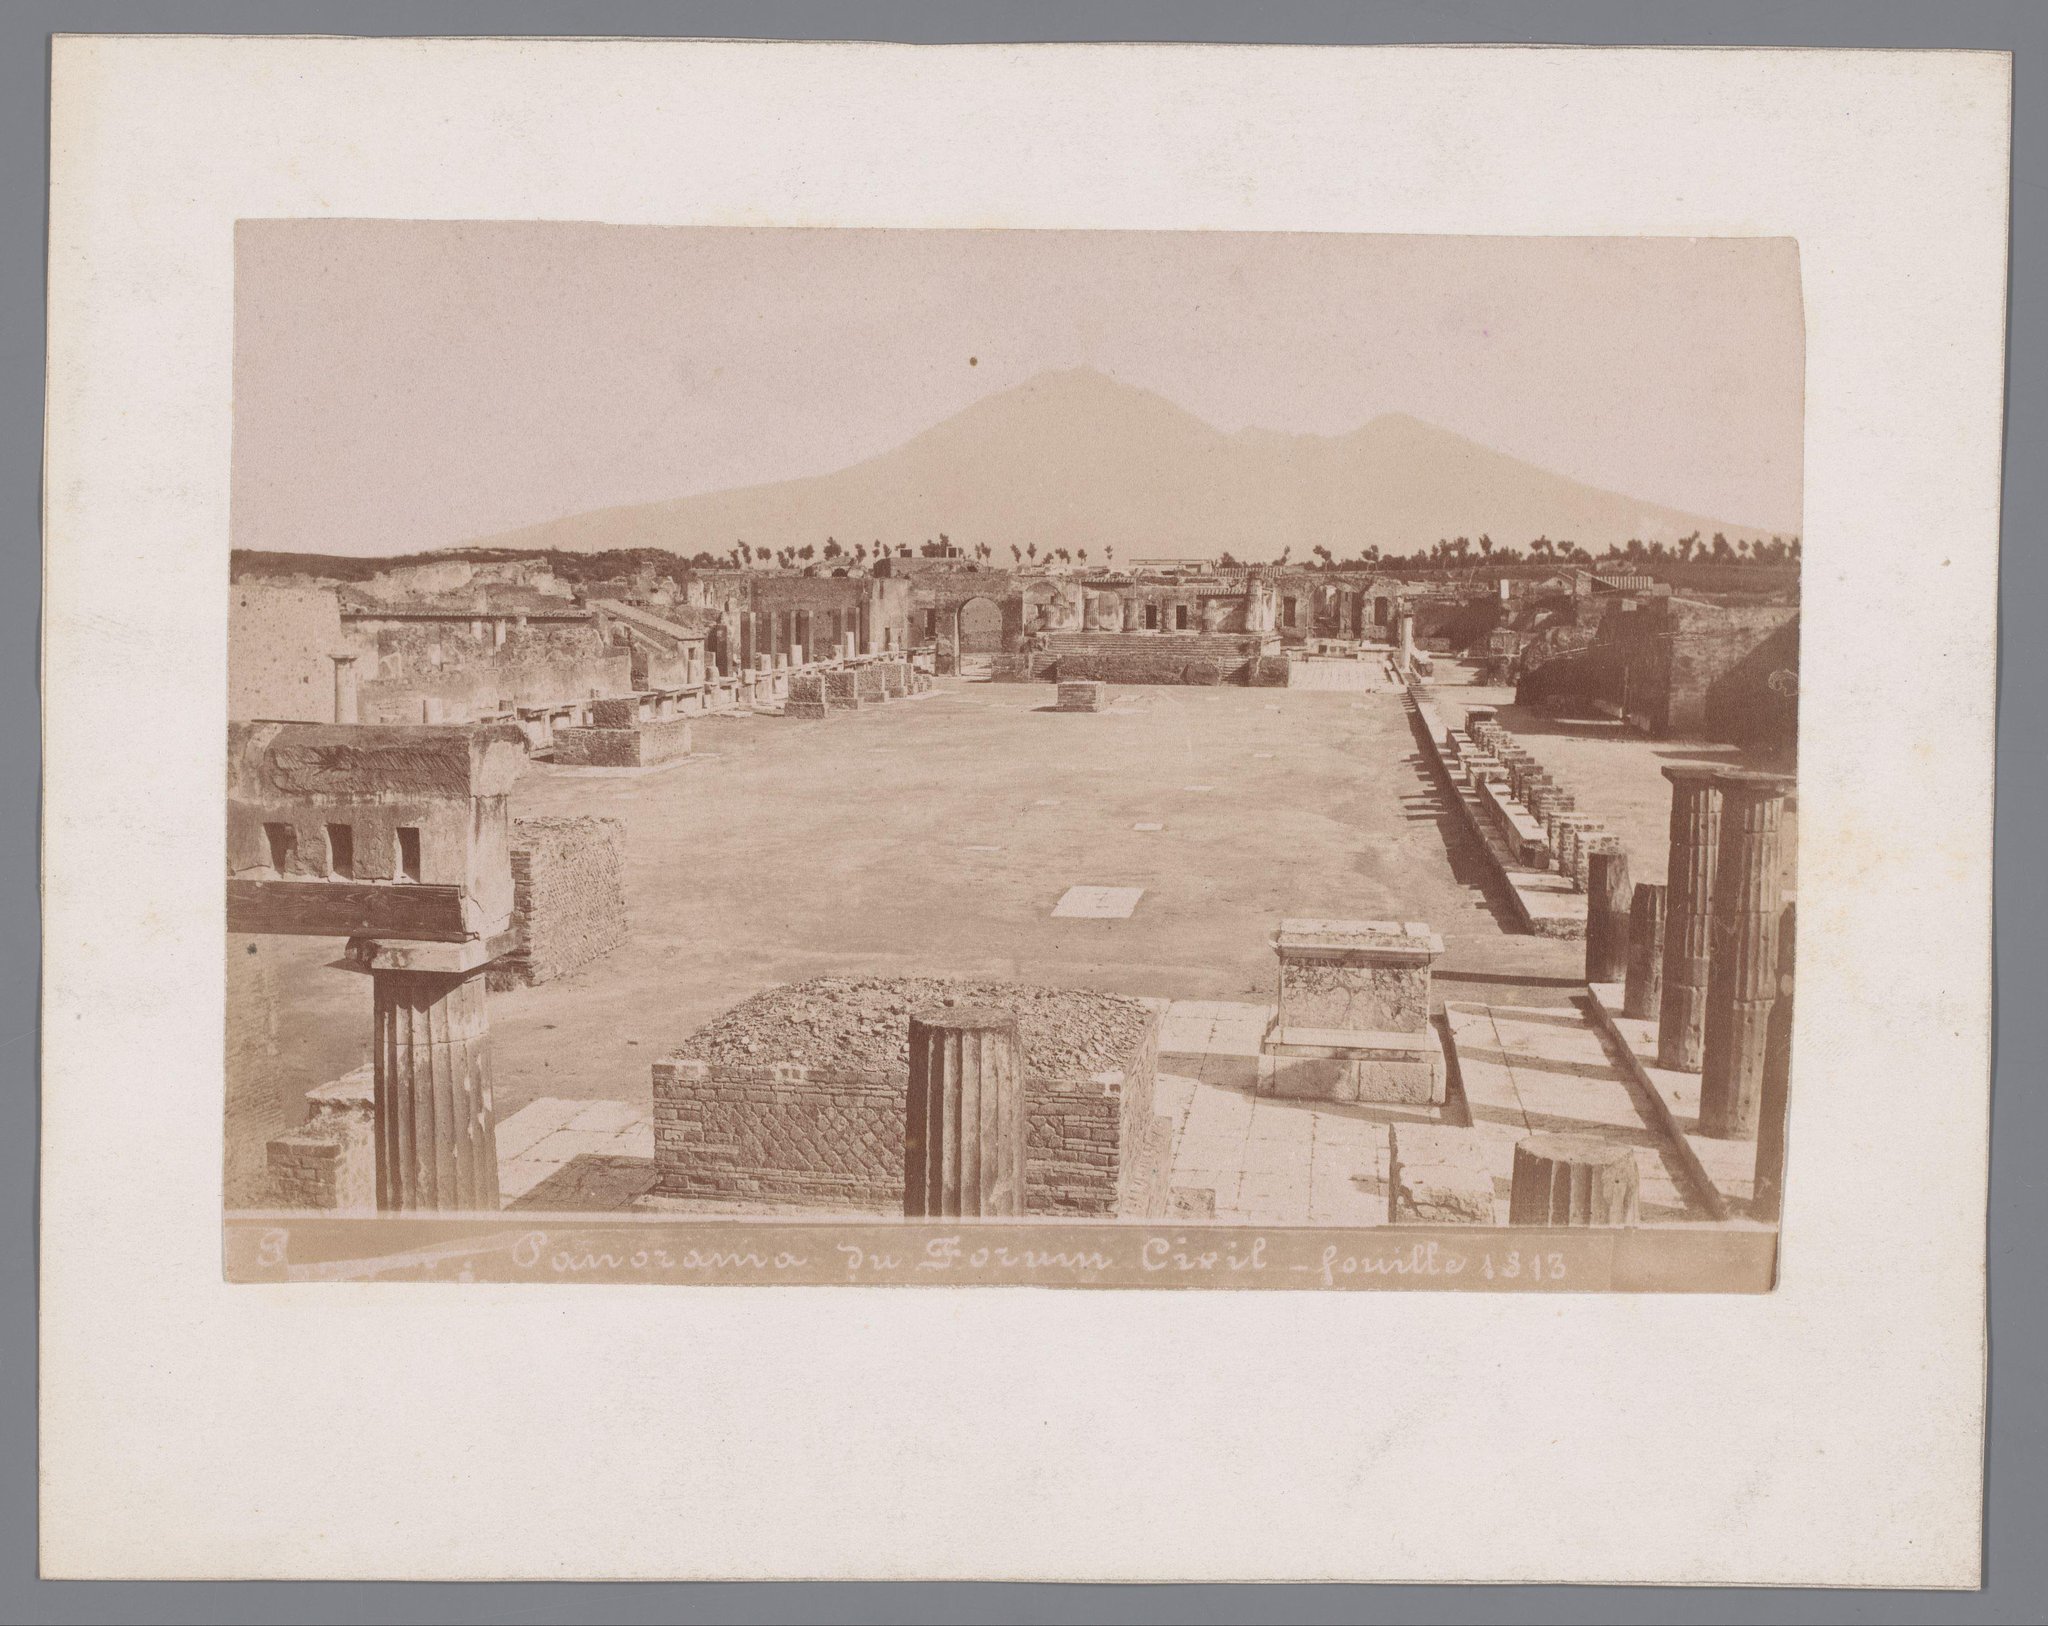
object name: photograph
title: Gezicht op het Forum te Pompeï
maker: giorgio sommer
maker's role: fotograaf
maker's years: 1834-1914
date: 1857-1914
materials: cardboard, paper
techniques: albumen print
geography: pompeii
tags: square, place, circus, etc., devastated, ruined place or city (~ warfare)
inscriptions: collector's mark: ‘VOSMAER’, number: ‘9’, inscription: ‘10’